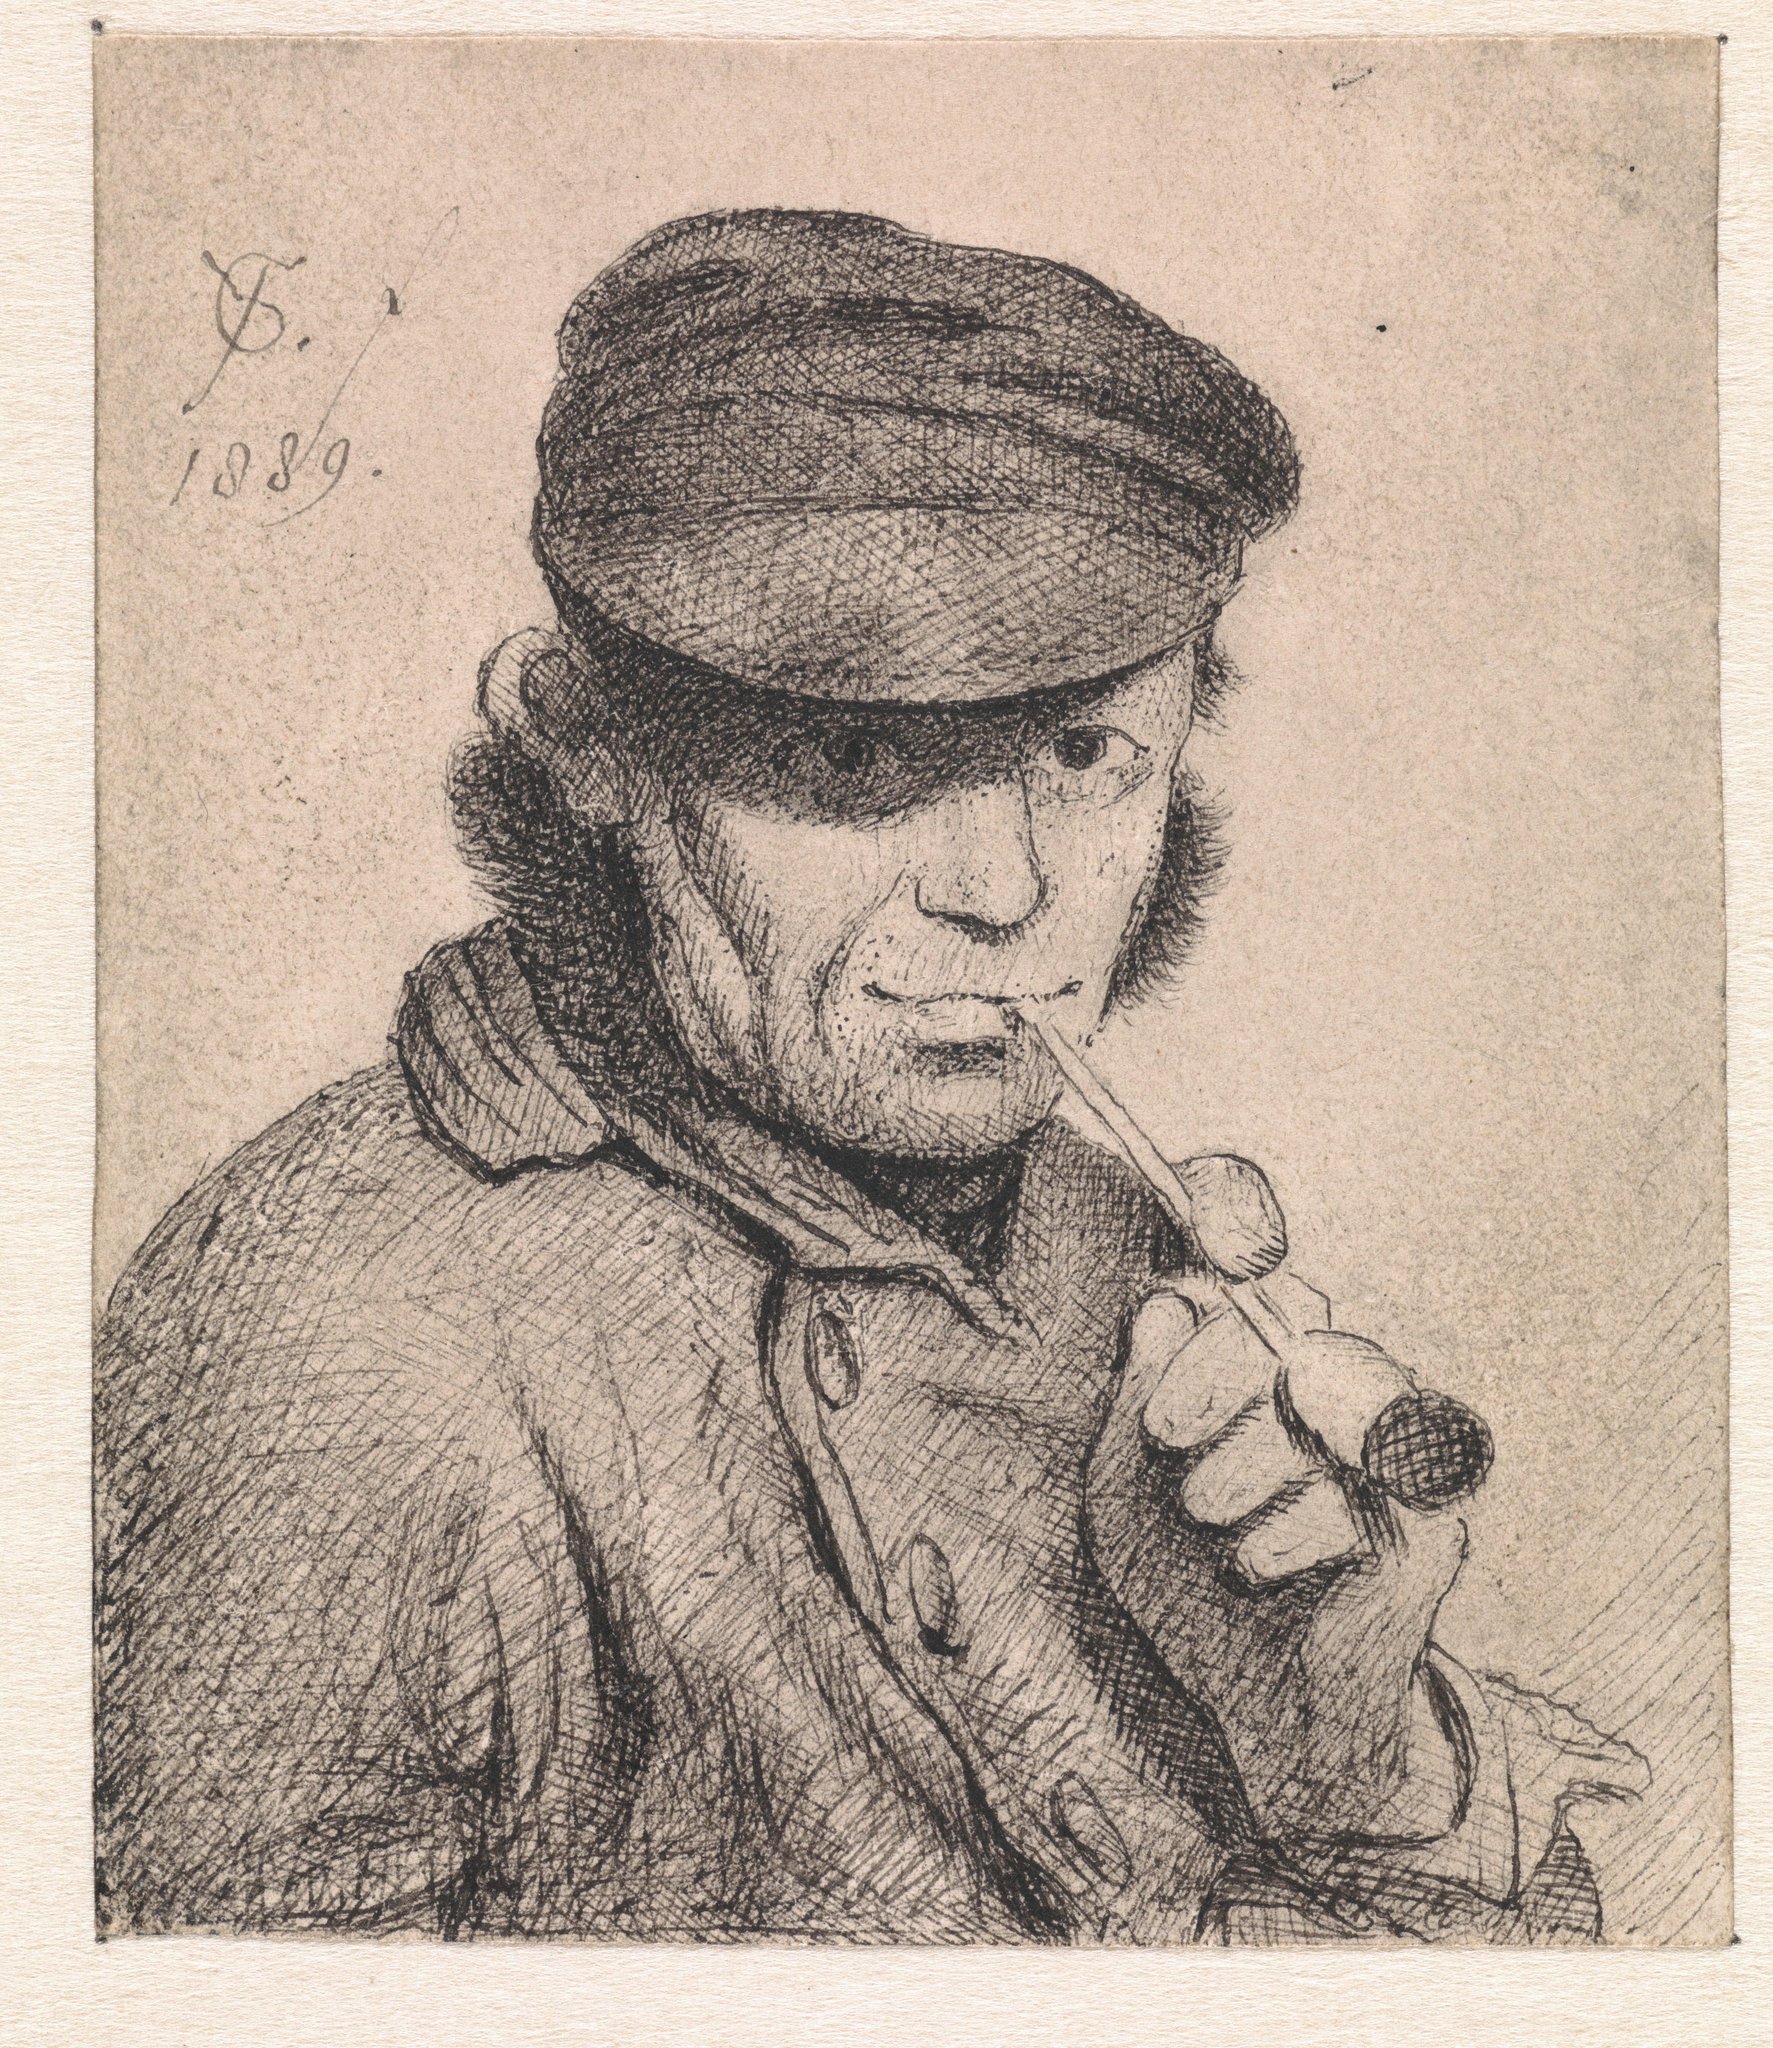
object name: drawing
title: Kees, de houtman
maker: cornelis van der griendt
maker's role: draughtsman, painter, print maker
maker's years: 1827-1918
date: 1889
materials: ink, paper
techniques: pen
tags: chest, bust, adult man, head-gear: hat, pipe ~ tobacco (+ taking (particular) foodstuffs: eating, drinking, smoking, chewing, etc.)